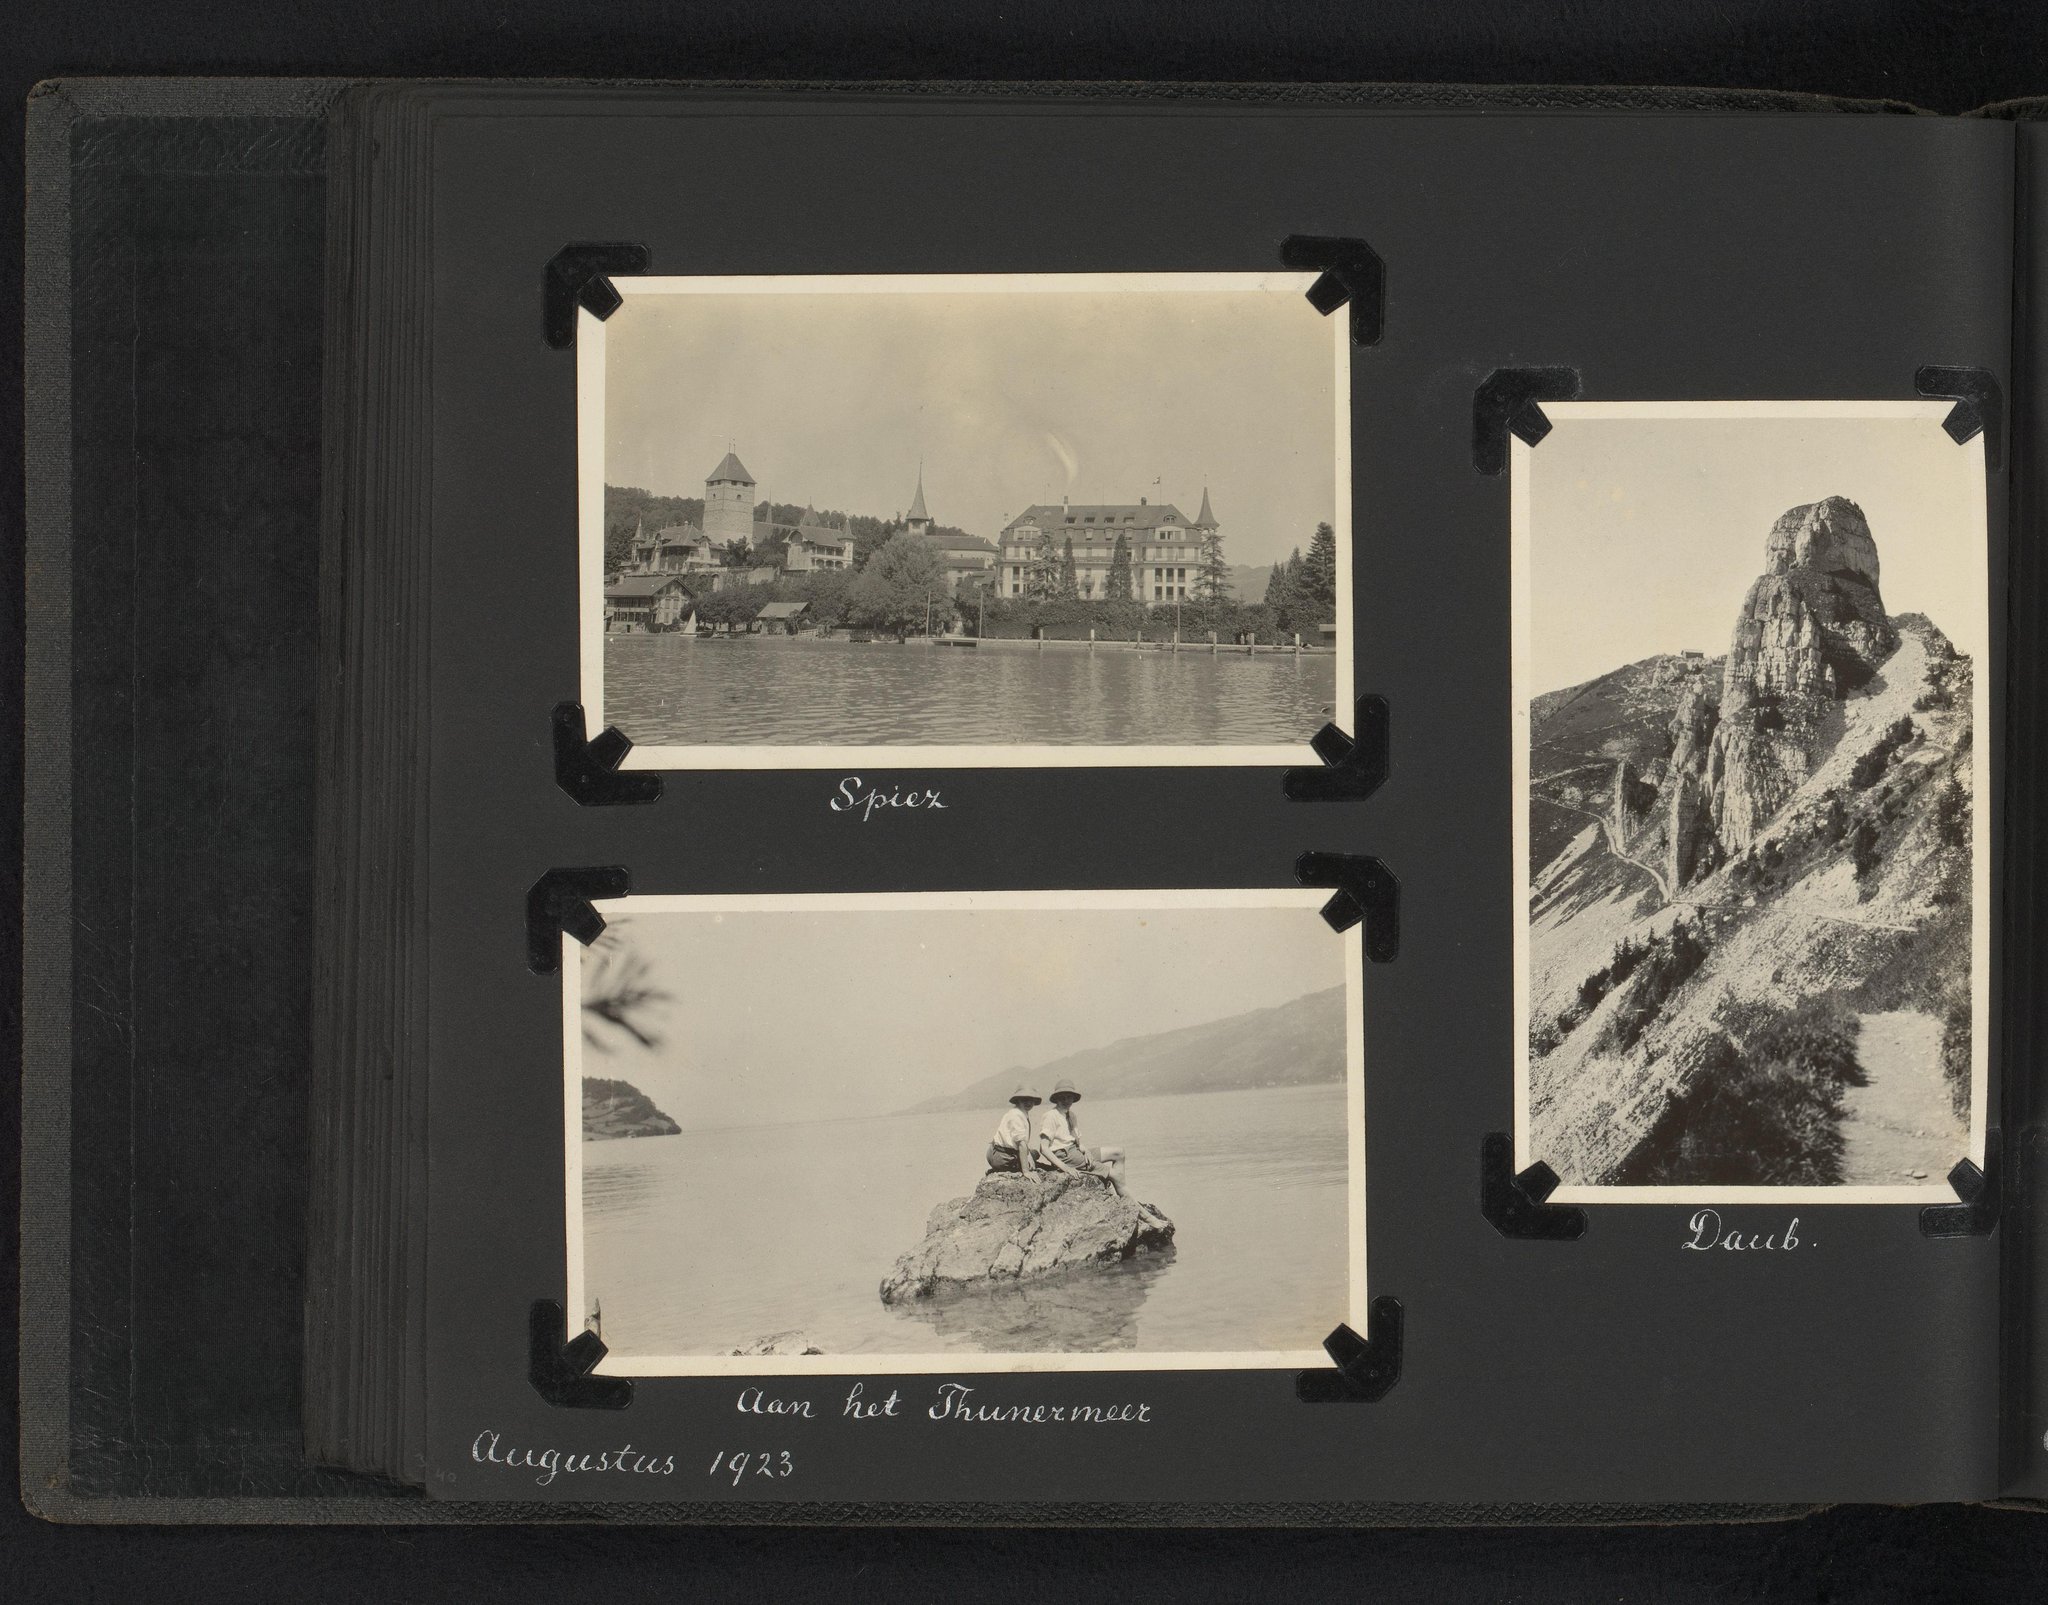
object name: photograph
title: Augustus 1923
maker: hendrik herman van den berg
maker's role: amateurfotograaf, jurist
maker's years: 1875-1944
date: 1908-1923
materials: paper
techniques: gelatin silver print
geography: bern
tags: amsterdam, carel frederik van den berg (cay), frank willem van den berg (1912-1998), village, lake, mountains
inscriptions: inscription: ‘Daub’, inscription: ‘Aan het Thunermeer’, inscription: ‘Spiez’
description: Deze foto's maken deel uit van een album.